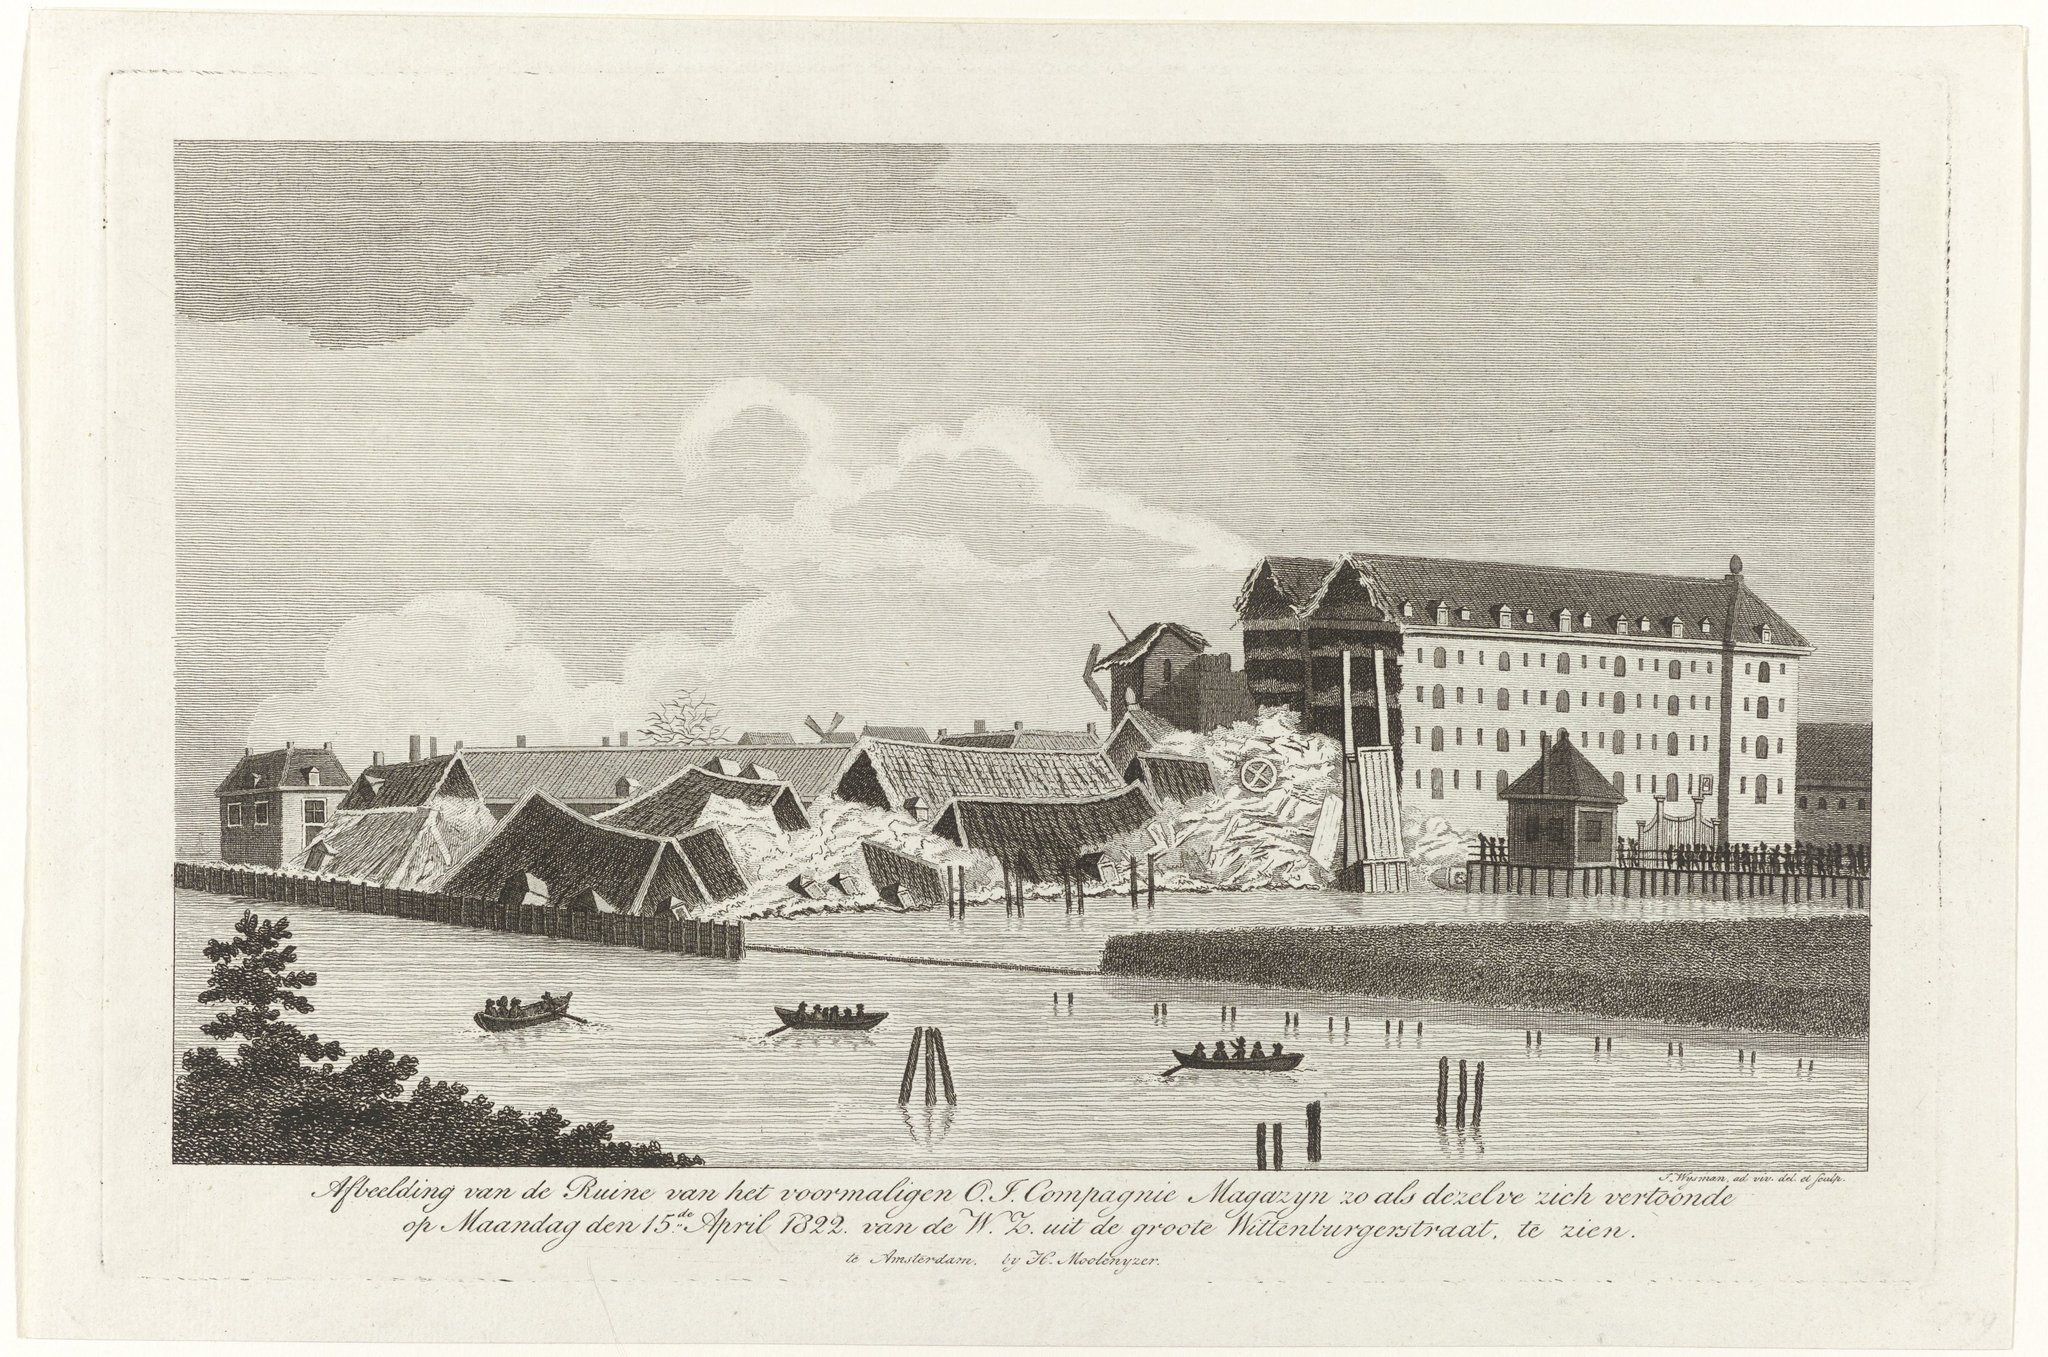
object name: print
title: Ruïne van het Oost-Indisch Zeemagazijn, 1822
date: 1822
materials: paper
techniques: engraving, etching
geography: amsterdam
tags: ruin of a building ~ architecture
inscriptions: collector's mark: Lugt 2228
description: Ruïne van het Oost-Indisch Zeemagazijn te Amsterdam, na de instorting op 13-14 april 1822. Zie ook de pendant.